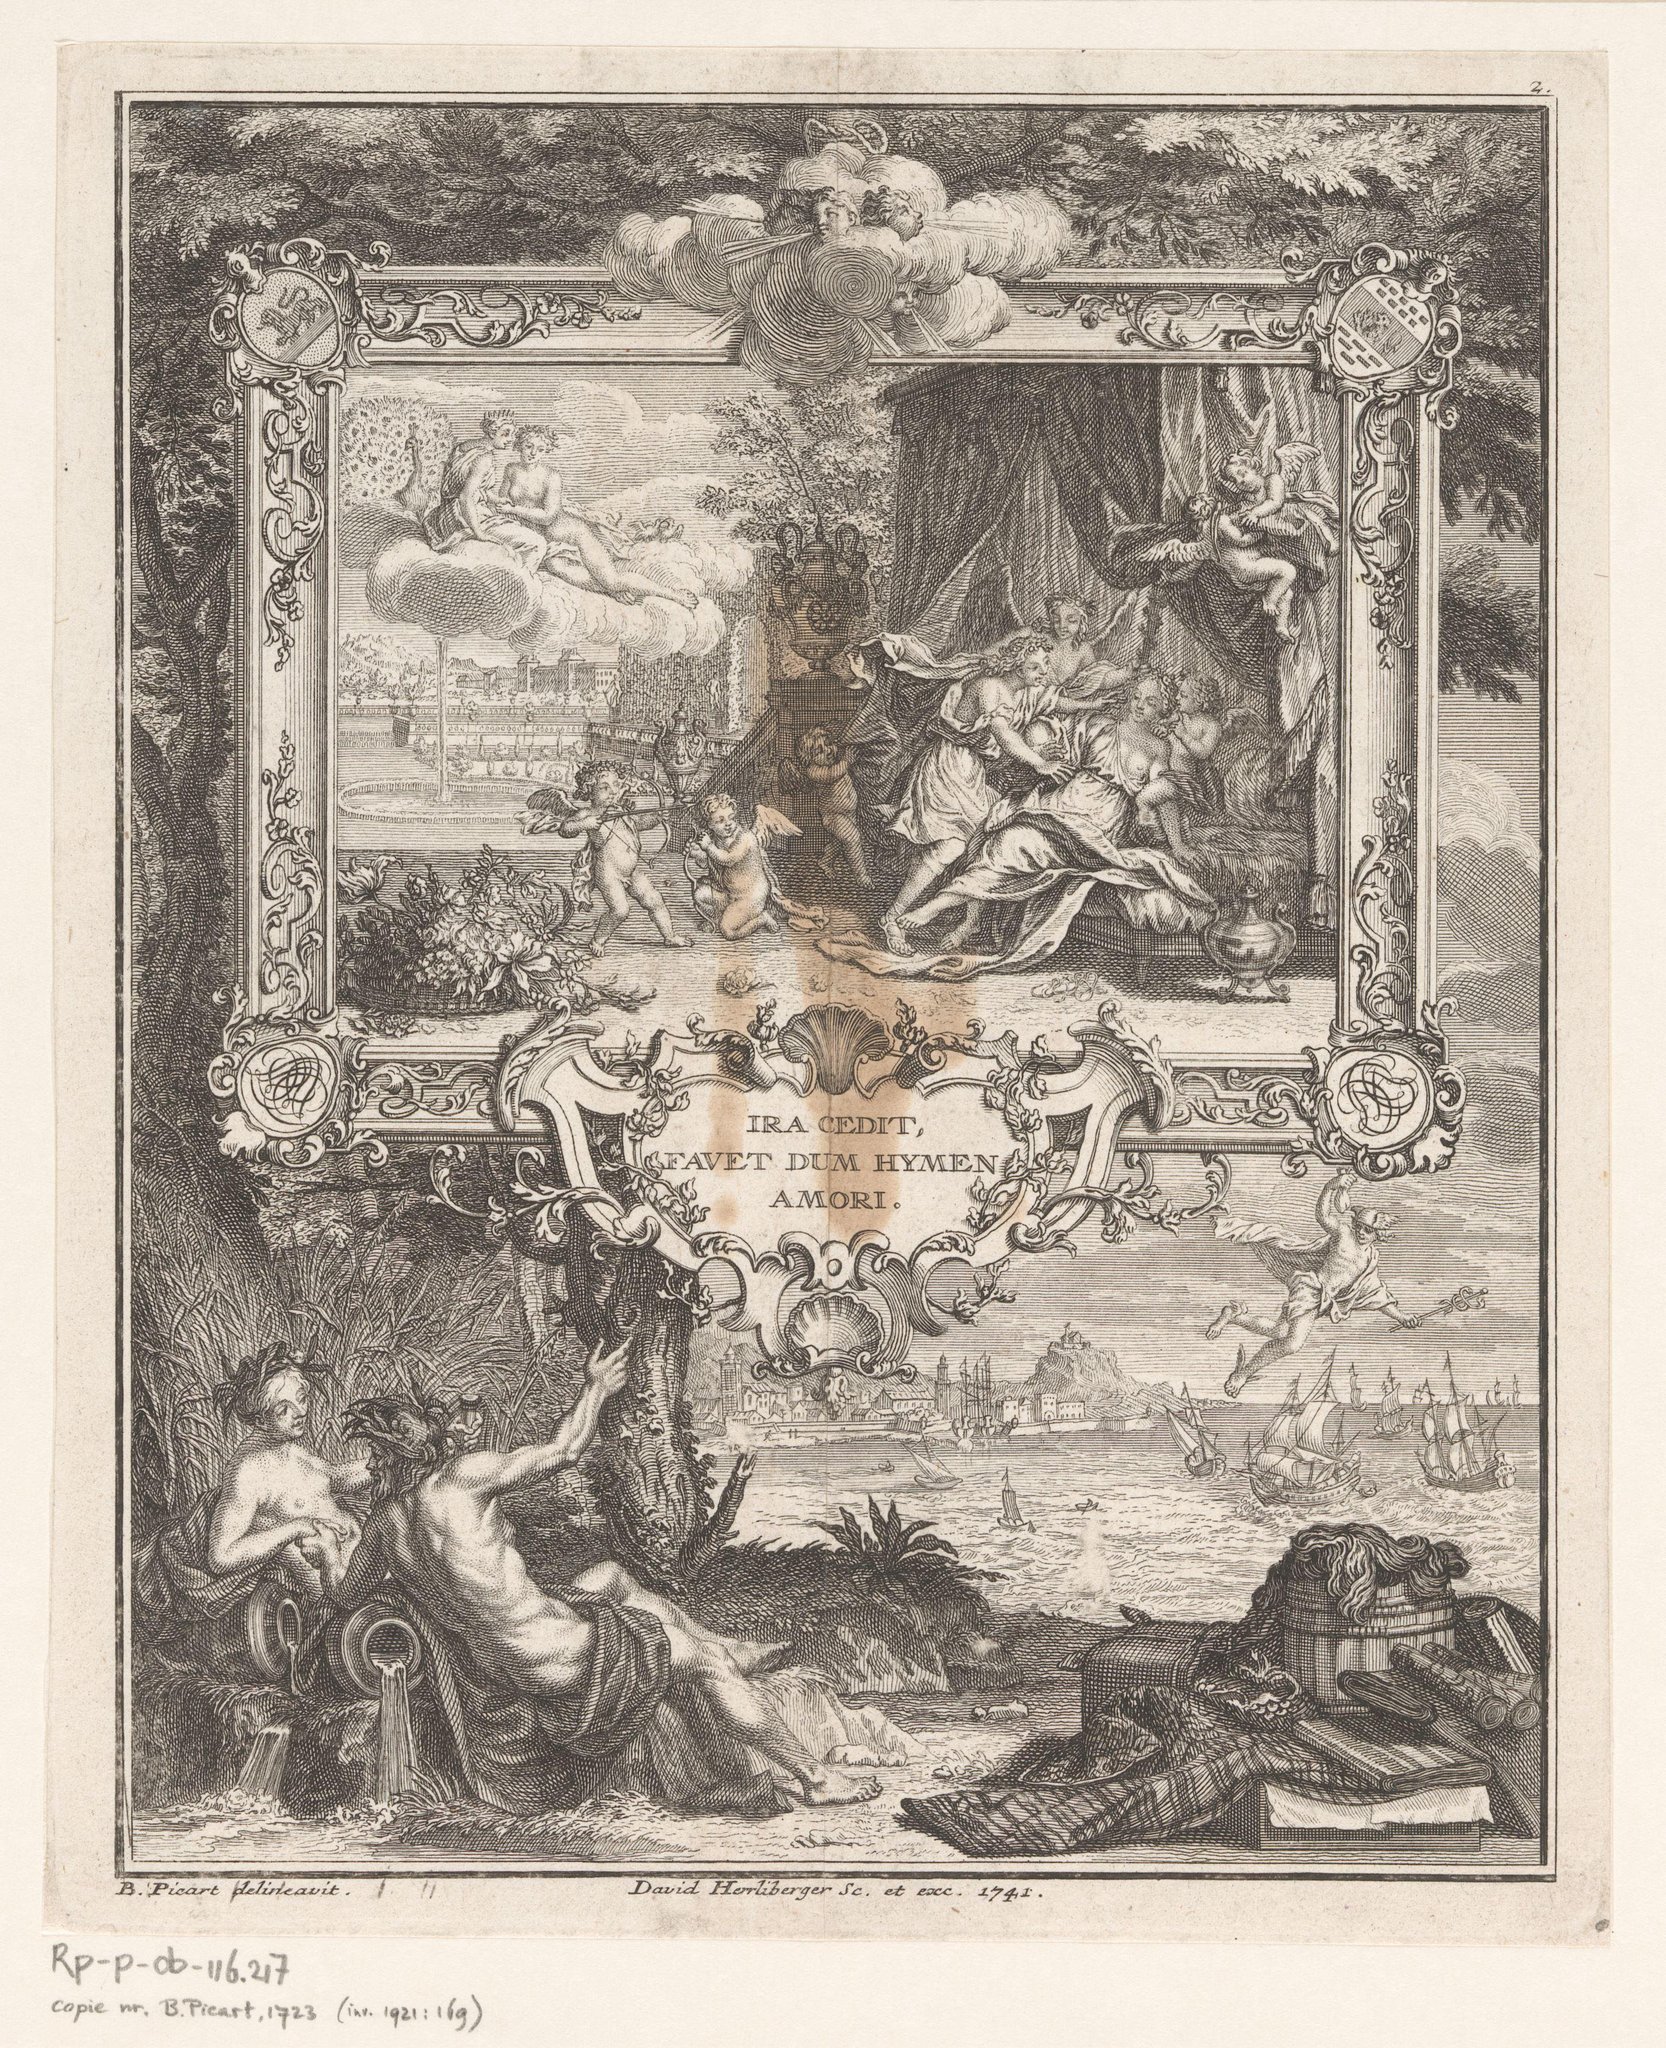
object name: print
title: Allegorische voorstelling ter gelegenheid van het huwelijk van David Leeuw van Lennep en Hester Barnaart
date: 1741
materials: paper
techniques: engraving, etching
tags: (story of) hymen(aeus), (story of) juno (hera), (story of) mercury (hermes), river personified, 'fiumi' (ripa), initial, marriage, married couple, 'matrimonium', (story of) venus (aphrodite), armorial bearing, heraldry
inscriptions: date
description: Allegorische voorstelling ter gelegenheid van het huwelijk van David Leeuw van Lennep en Hester Barnaart te Haarlem op 25 mei 1723. De echtgenoot wordt door Hymen naar het huwelijksbed gebracht, waar zij hem licht afweert. Juno, als beschermster van de vrouwen, en Venus, als godin van de liefde, zitten boven op een wolk. De voorstelling is gevat in een ornamentele lijst. Onder de stroomgoden van het IJ en het Spaarne. Handelswaar, schepen en de handelsgod Mercurius geven de bezigheden van het echtpaar als kooplieden weer. Onder de voorstelling het devies: Ira cedit, favet dum hymen amori. Rechtsboven genummerd: 2.